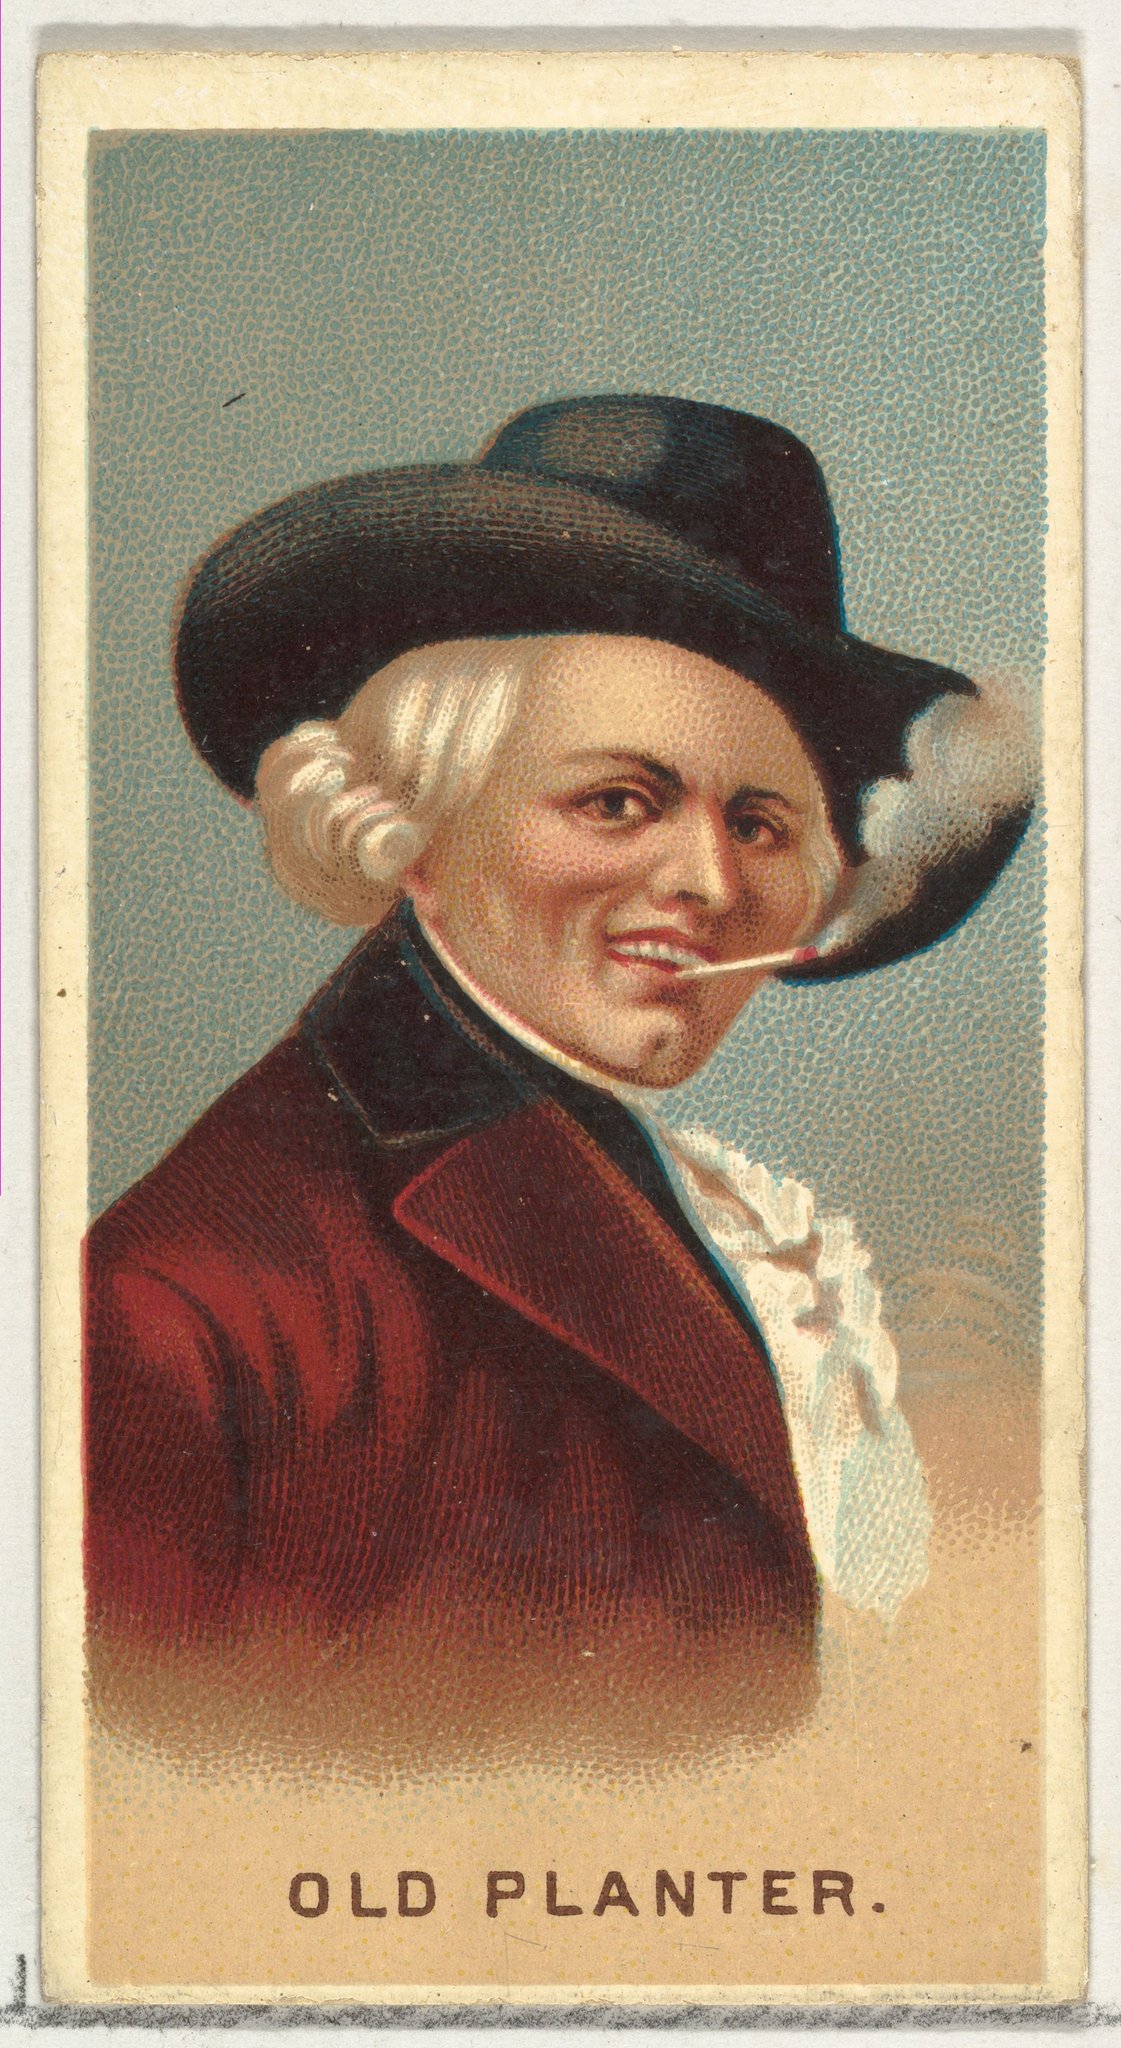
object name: print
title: Old Planter, from World's Smokers series (N33) for Allen & Ginter Cigarettes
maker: allen & ginter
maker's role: publisher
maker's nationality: american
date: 1888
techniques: color lithograph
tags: men,smoking